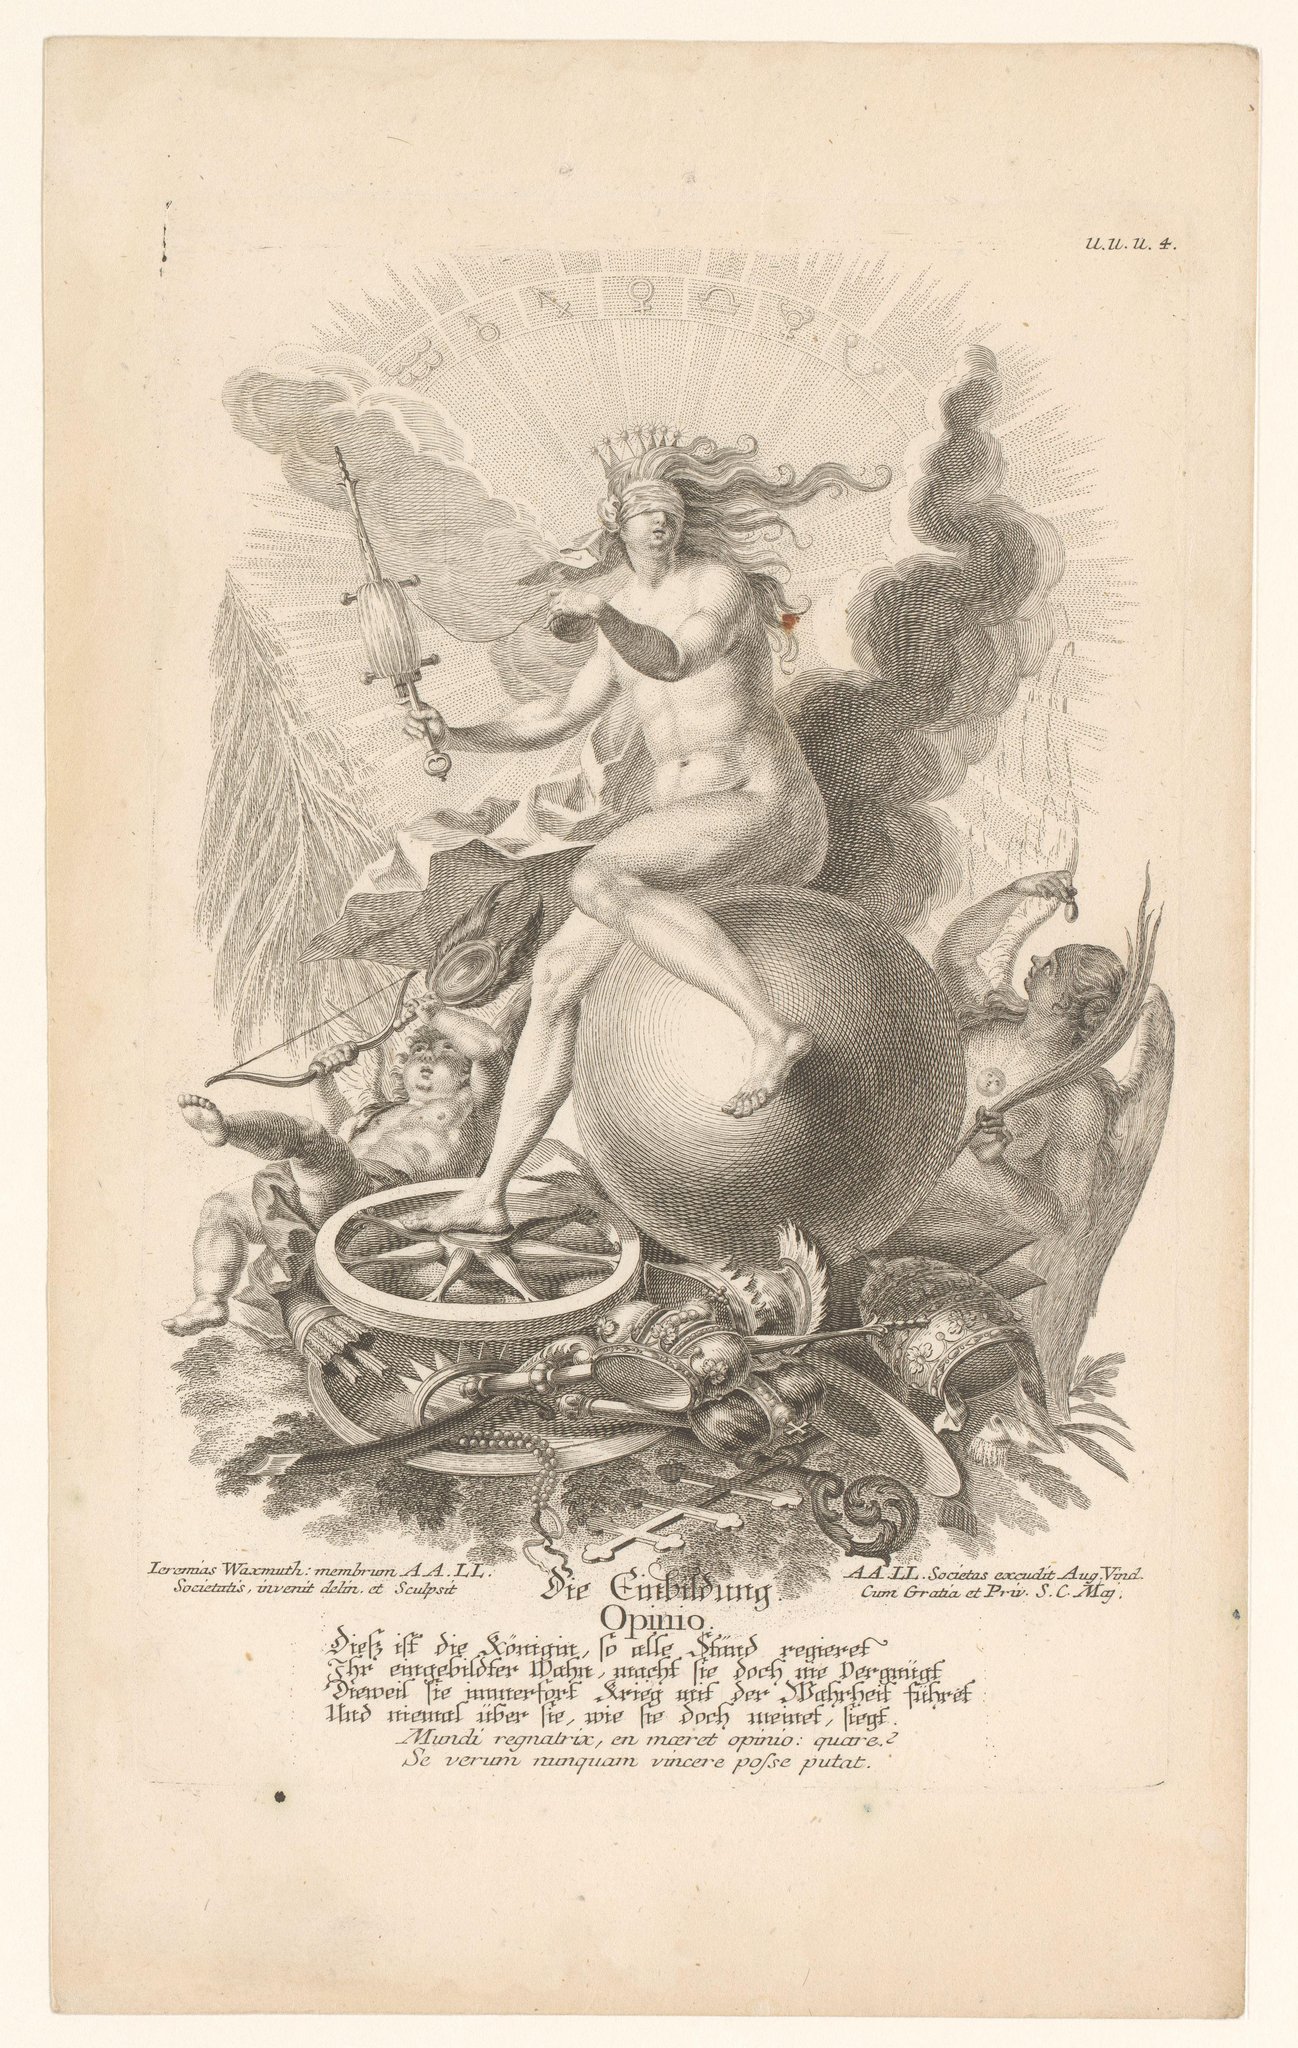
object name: print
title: Allegorieën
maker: jeremias wachsmuth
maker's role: draughtsman, print maker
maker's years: 1711-1771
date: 1721-1771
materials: paper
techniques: etching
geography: augsburg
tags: crown (symbol of sovereignty), insignia of bishop, e.g. mitre, crozier, pearl; pearl necklace, (story of) cupid, amor (eros), opinion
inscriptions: collector's mark: Lugt 2166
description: Opinio zit geblinddoekt en gekroond op een bol. In haar hand heeft ze een spintol. Ze staat met een voet op een wiel en onder de bol liggen kronen, helmen en een mijter. Links is Cupido achterover gevallen. Rechts een vrouw met palmtak en vleugels die een parel bekijkt. Met vierregelig vers in het Duits en twee regels in het Latijn onder de prent. Rechtsboven genummerd: u.u.u.4.